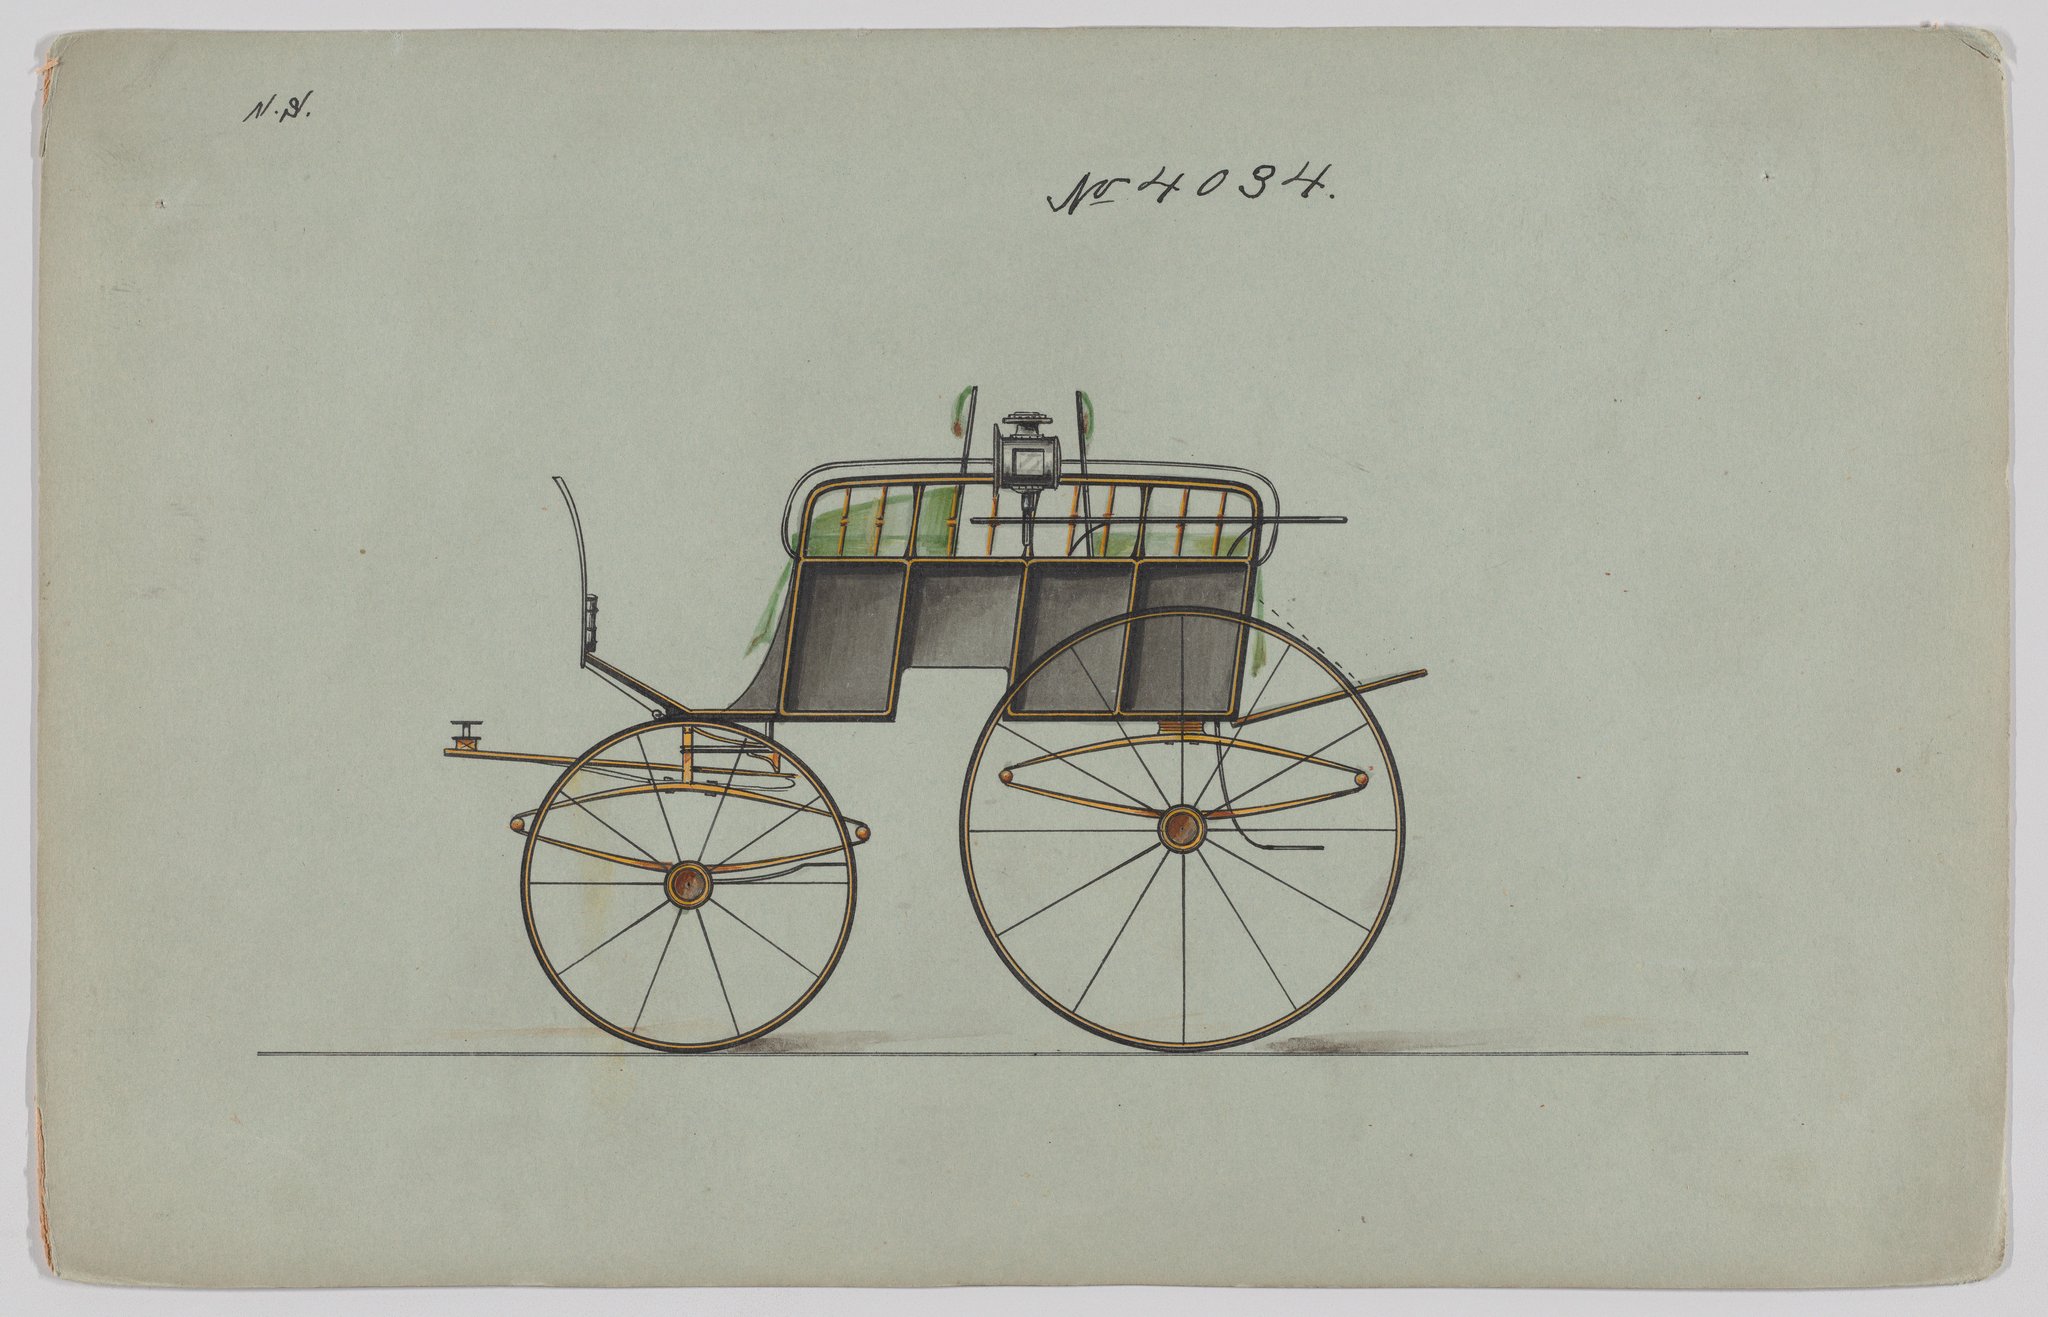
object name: drawing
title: Design for Dos-a-dos Phaeton, no. 4034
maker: brewster & co.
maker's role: manufacturer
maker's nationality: american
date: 1889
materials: gouache, gum arabic, ink, watercolor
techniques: pen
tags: carriages